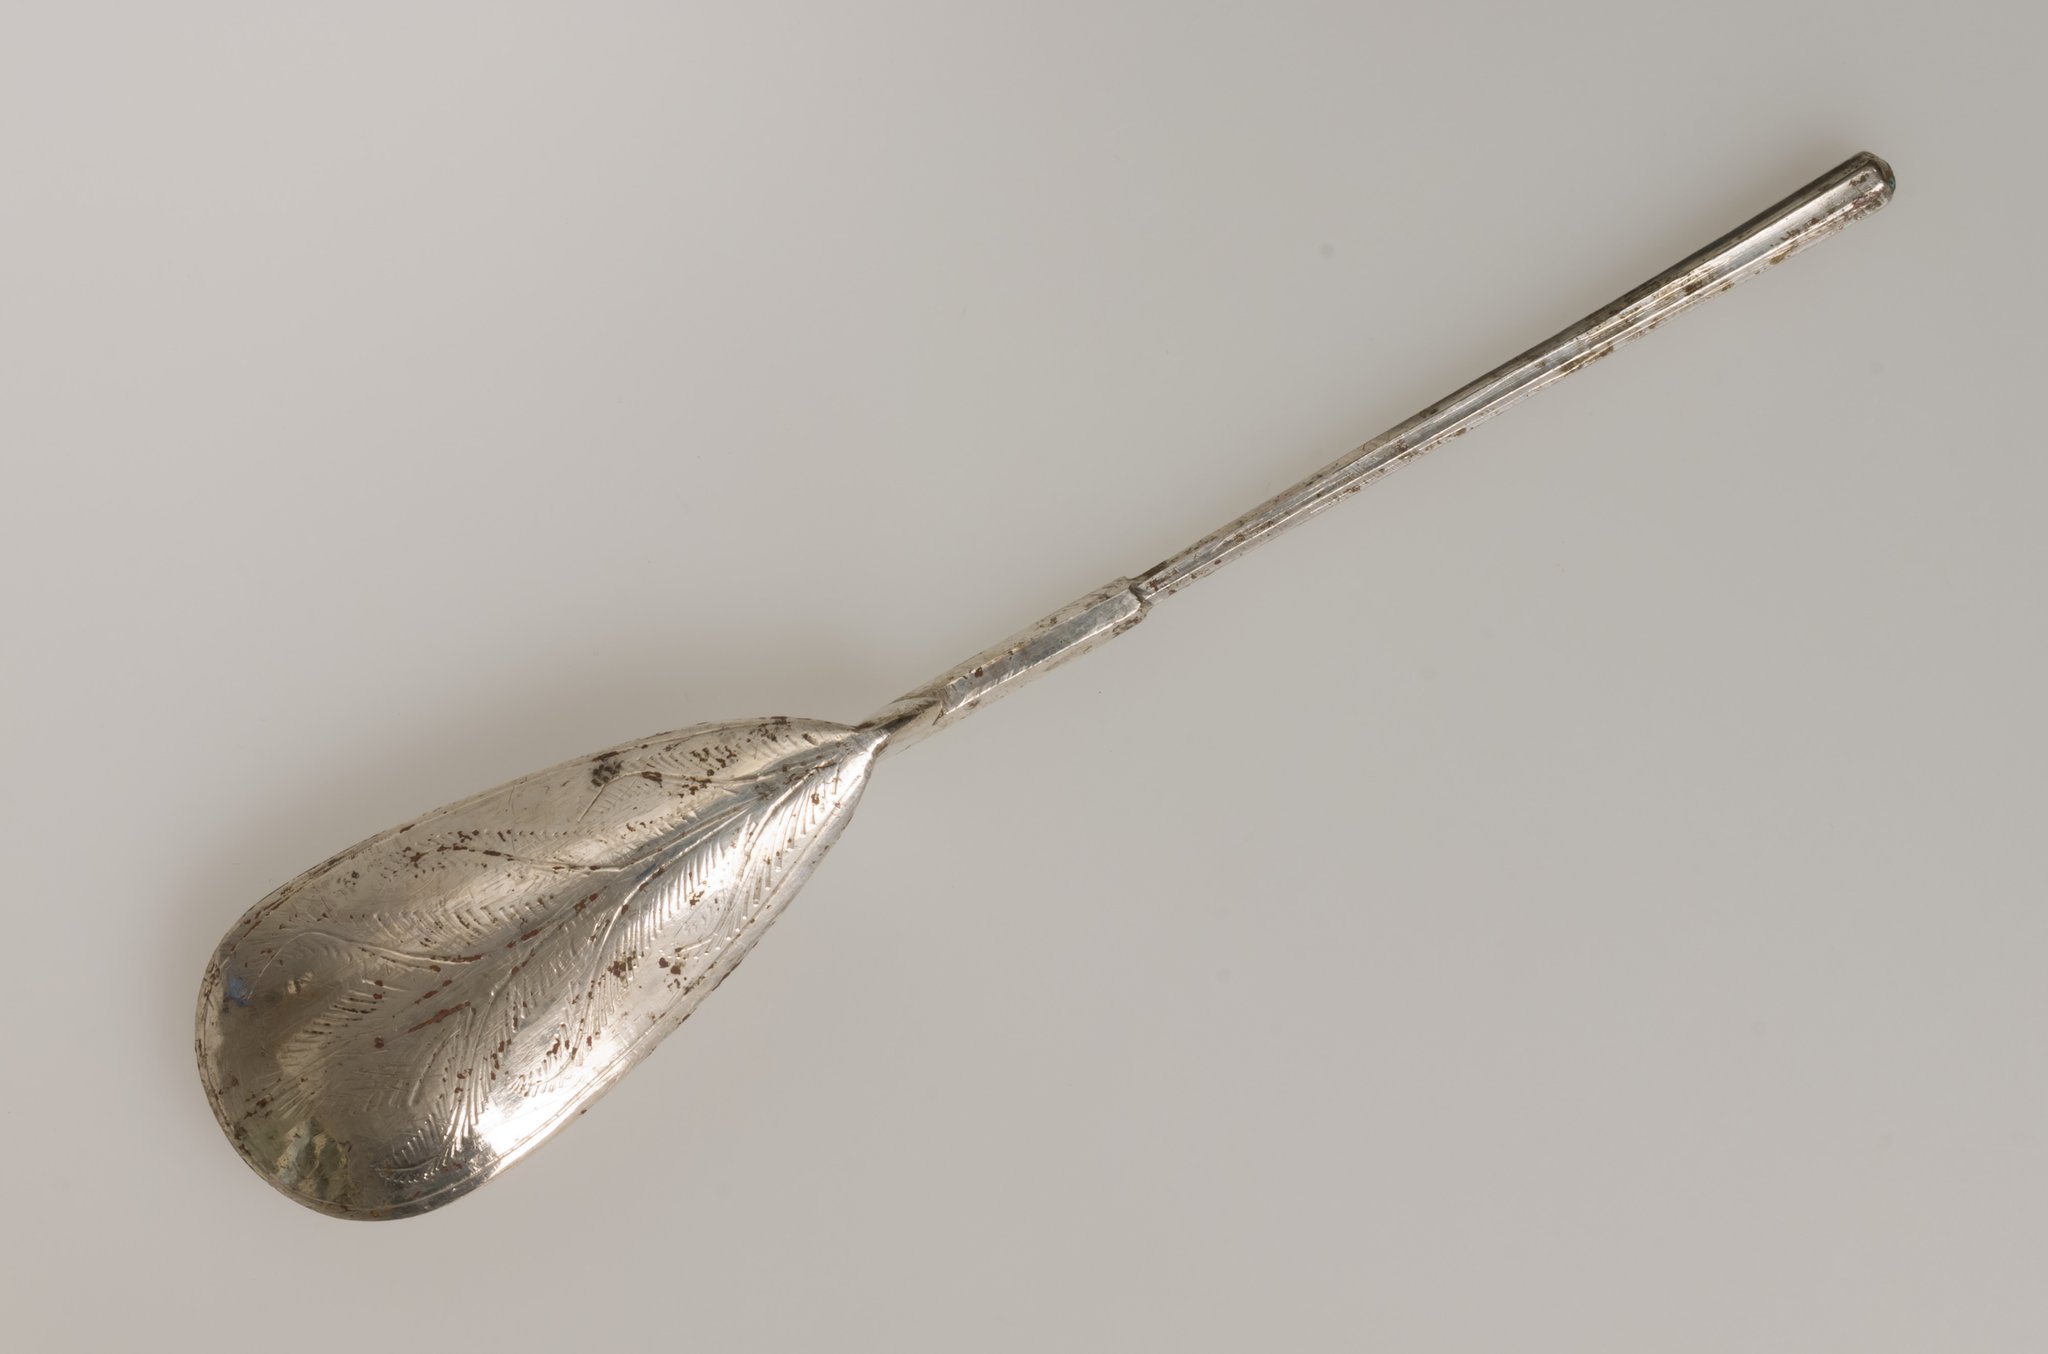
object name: spoon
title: Spoon with Palm Fronds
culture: byzantine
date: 401-600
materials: silver